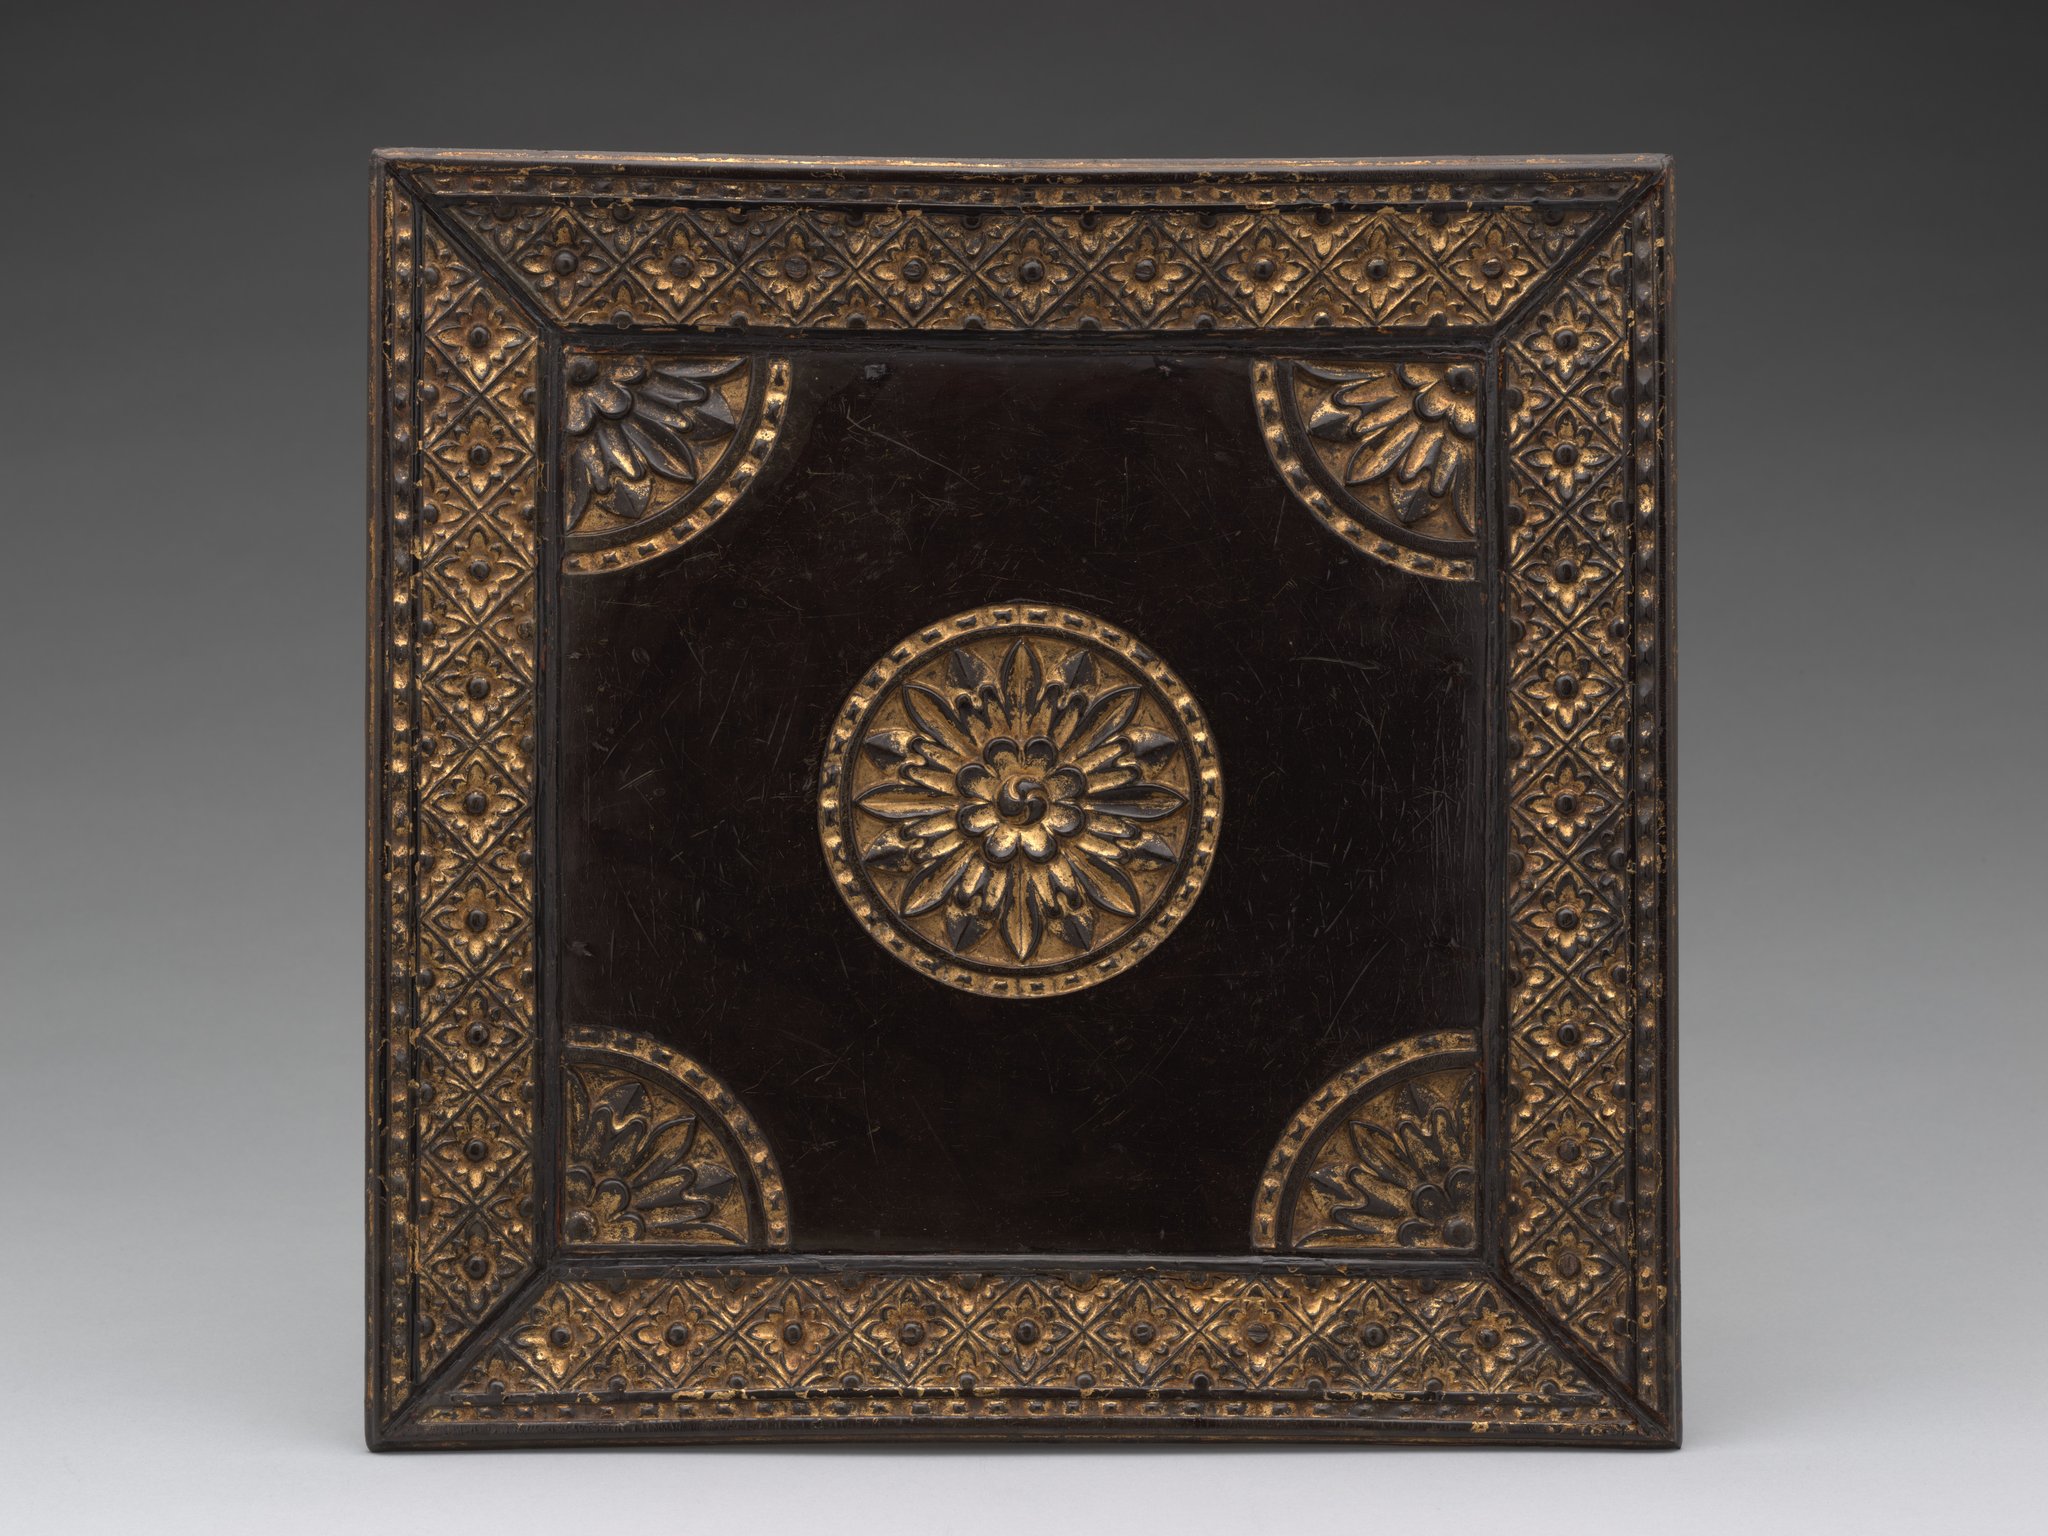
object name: square tray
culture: japanese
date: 1201-1400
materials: gold, lacquer